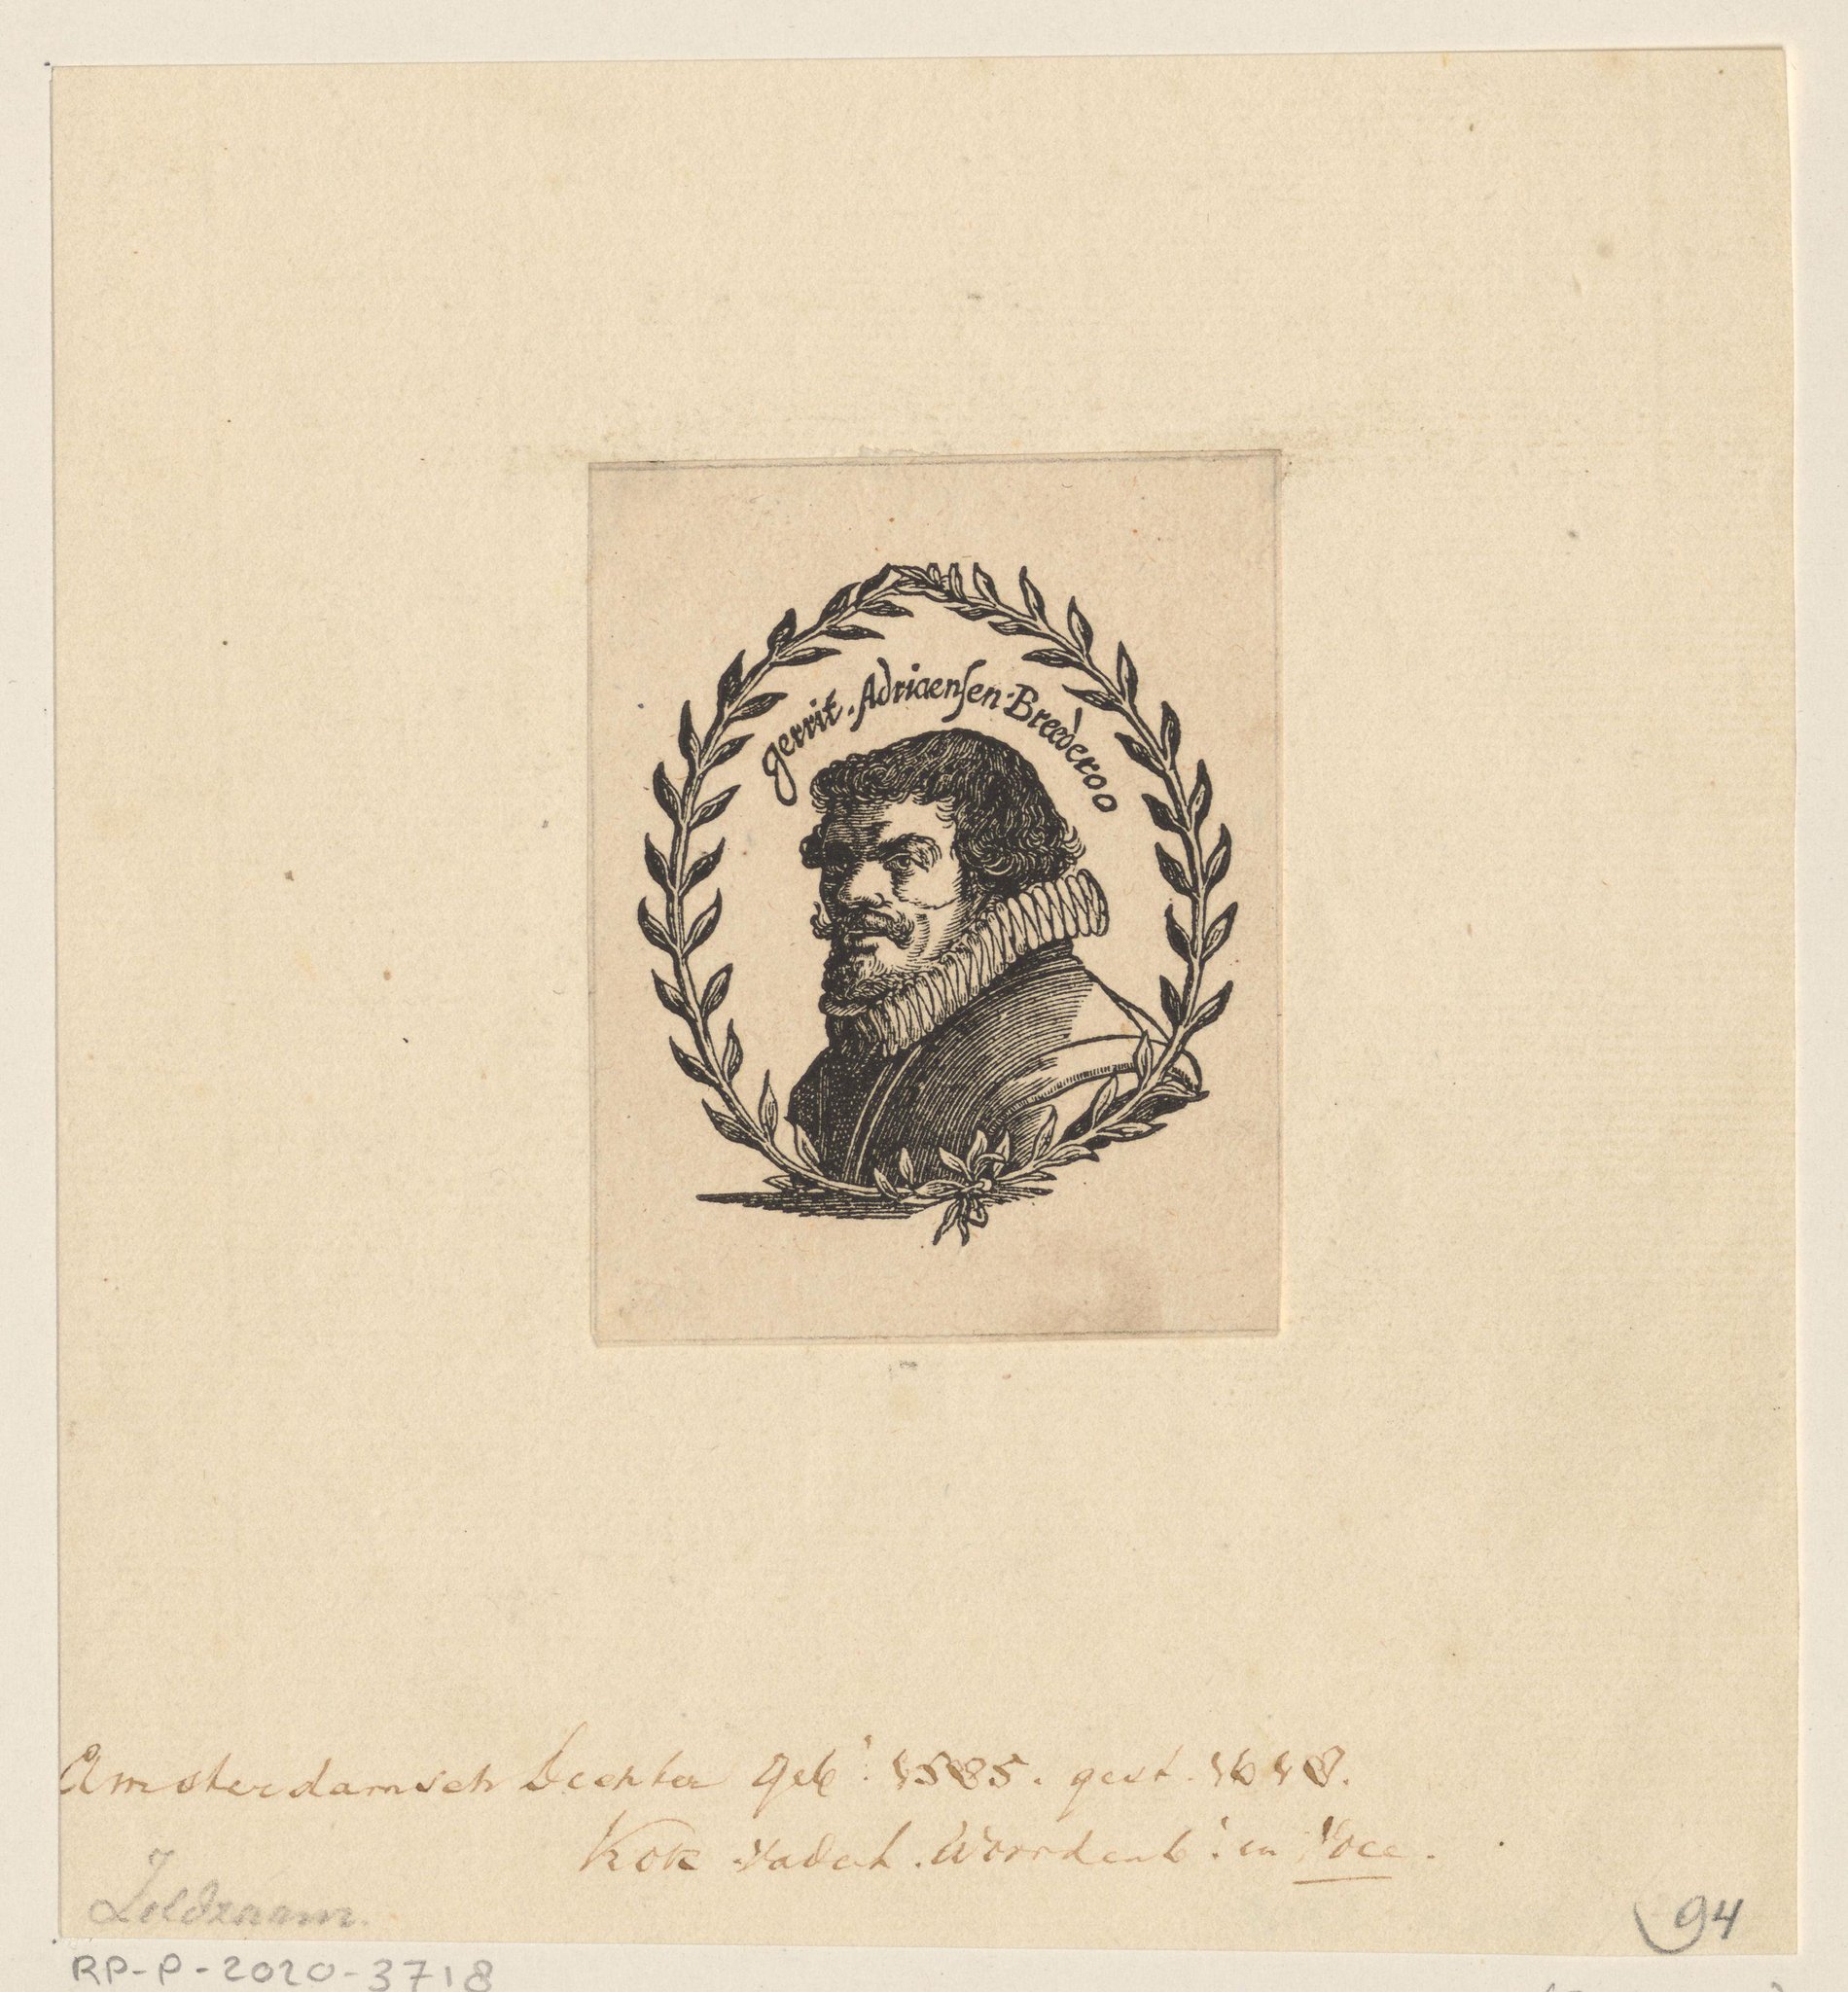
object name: print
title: Portret van Gerbrand Adriaensz. Bredero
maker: Anonymous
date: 1600-1649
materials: paper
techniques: woodcut, pasting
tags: gerbrand adriaensz. bredero, historical persons, writer, poet, author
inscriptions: inscription: ‘Amsterdamsch dichter geb: 1585. gest. 1648/ Kok vaderl. Woordenb: [...]’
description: Prent mogelijk uit: Bredero, Gerbrand Adriaensz. Alle de wercken (...). Amsterdam: Joost Hartgers, 1644. Mogelijk ook gebruikt in andere publicaties.